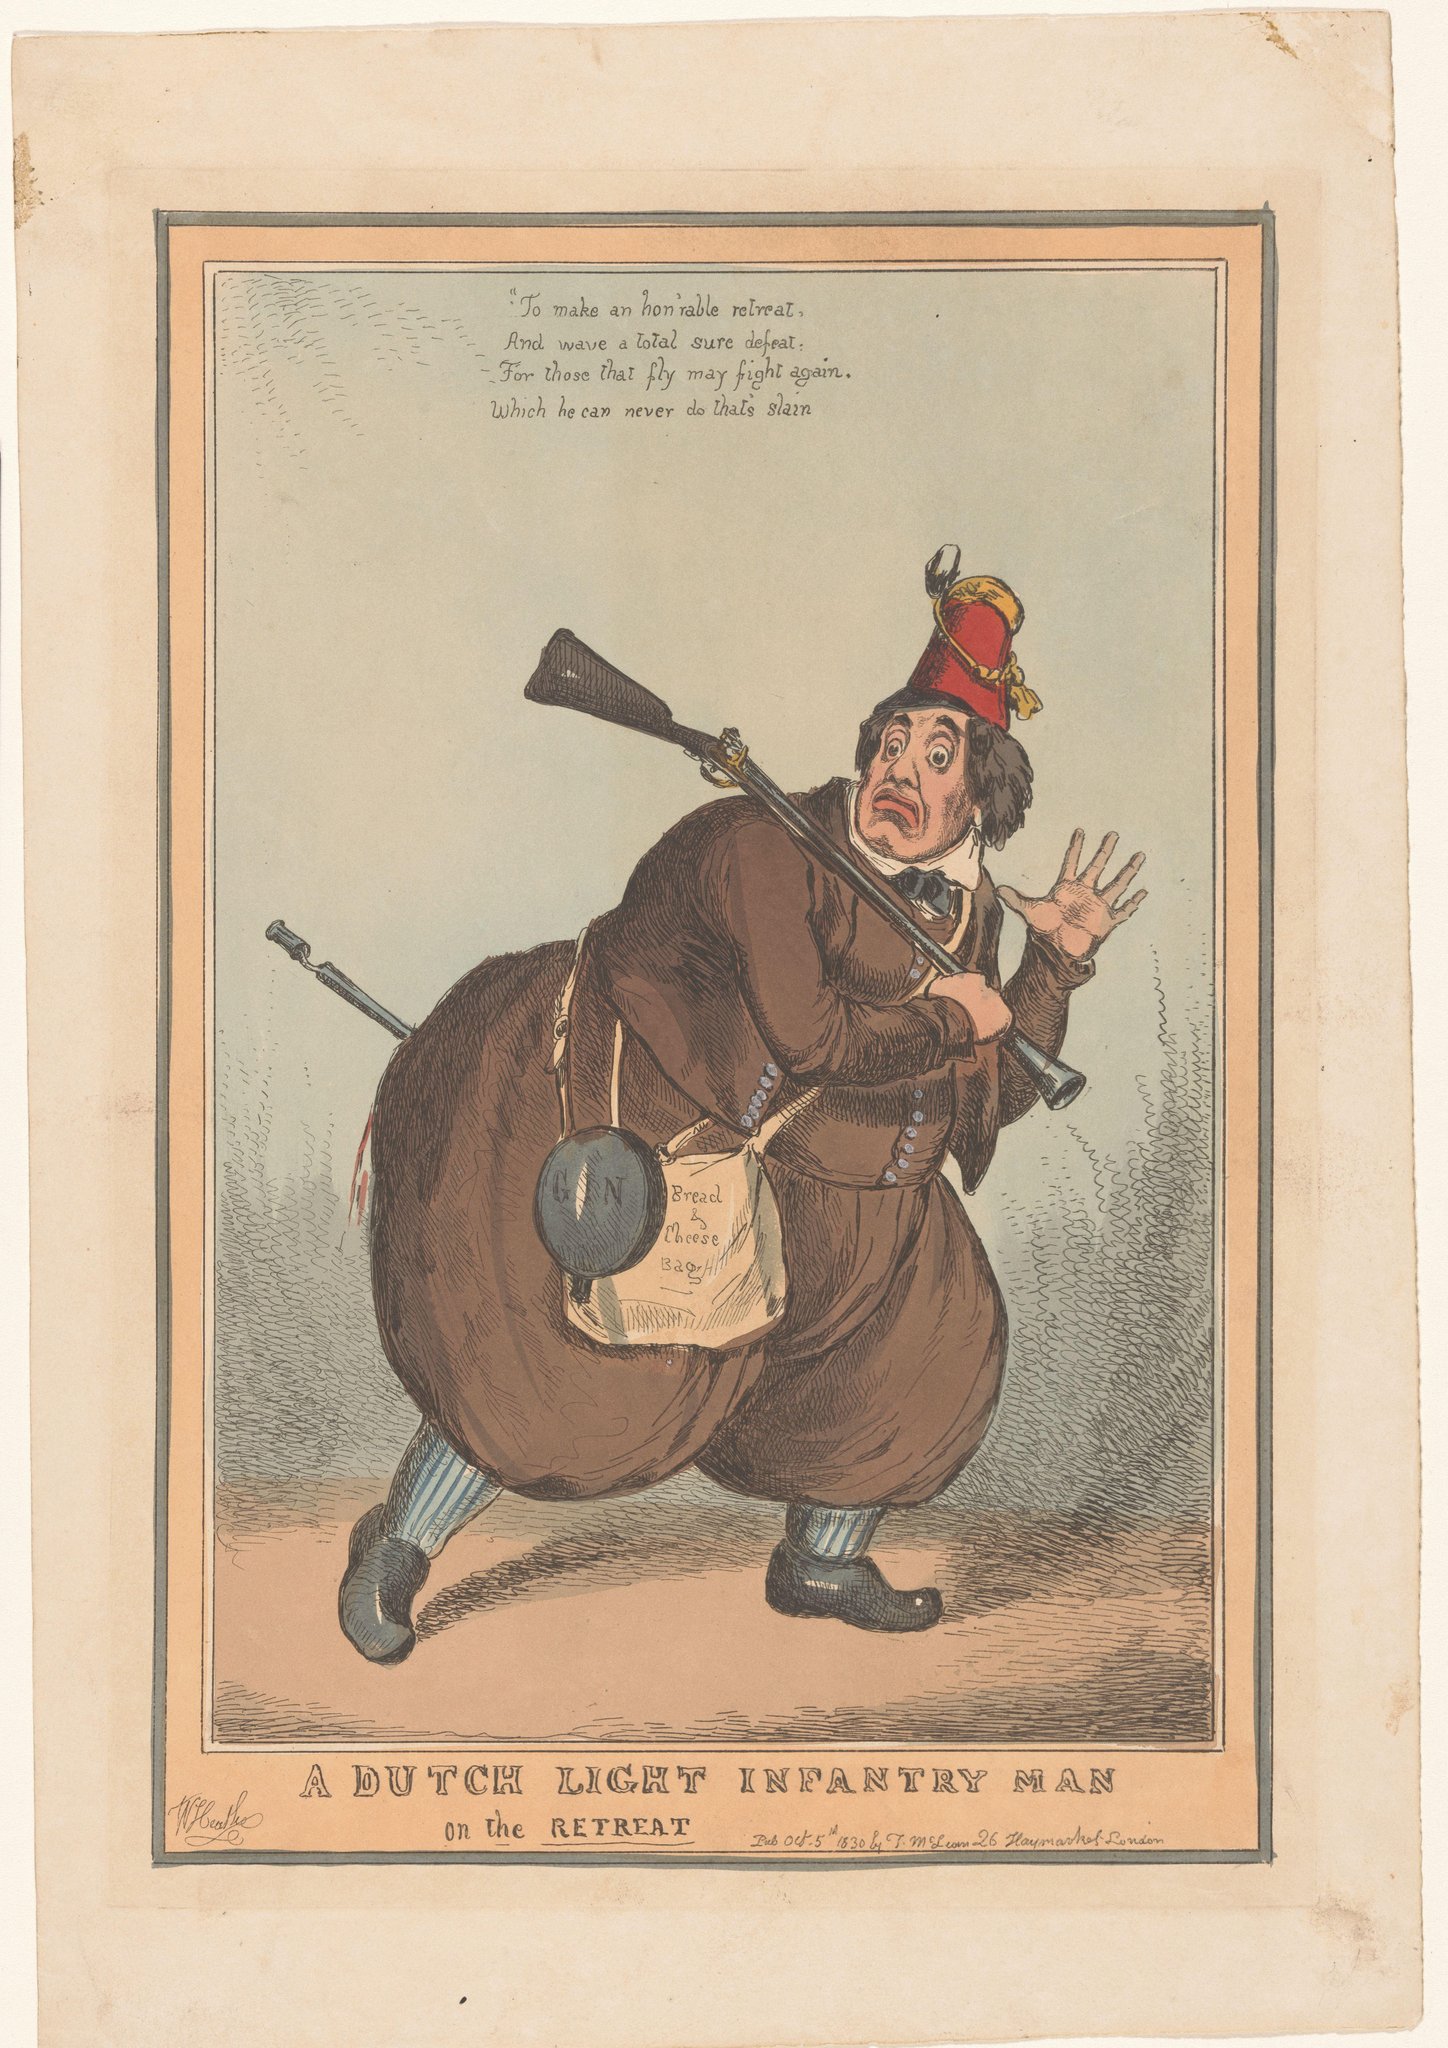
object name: cartoon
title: A Dutch light infantry man on the retreat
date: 1830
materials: paper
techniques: etching, hand coloring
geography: england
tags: fat (human type), private soldier (+ infantry), political caricatures and satires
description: Spotprent op de Nederlandse infanterie. Een zwaar gebouwde soldaat met angstige blik en geweer over de schouder trekt zich terug. Om de schouder een tas met brood en kaas, om de middel een veldfles met jenever. Bovenaan een vierregelig vers in het Engels. Spotprent naar aanleiding van de terugtocht van het Nederlandse leger in oktober 1830 tijdens de Belgische Opstand.